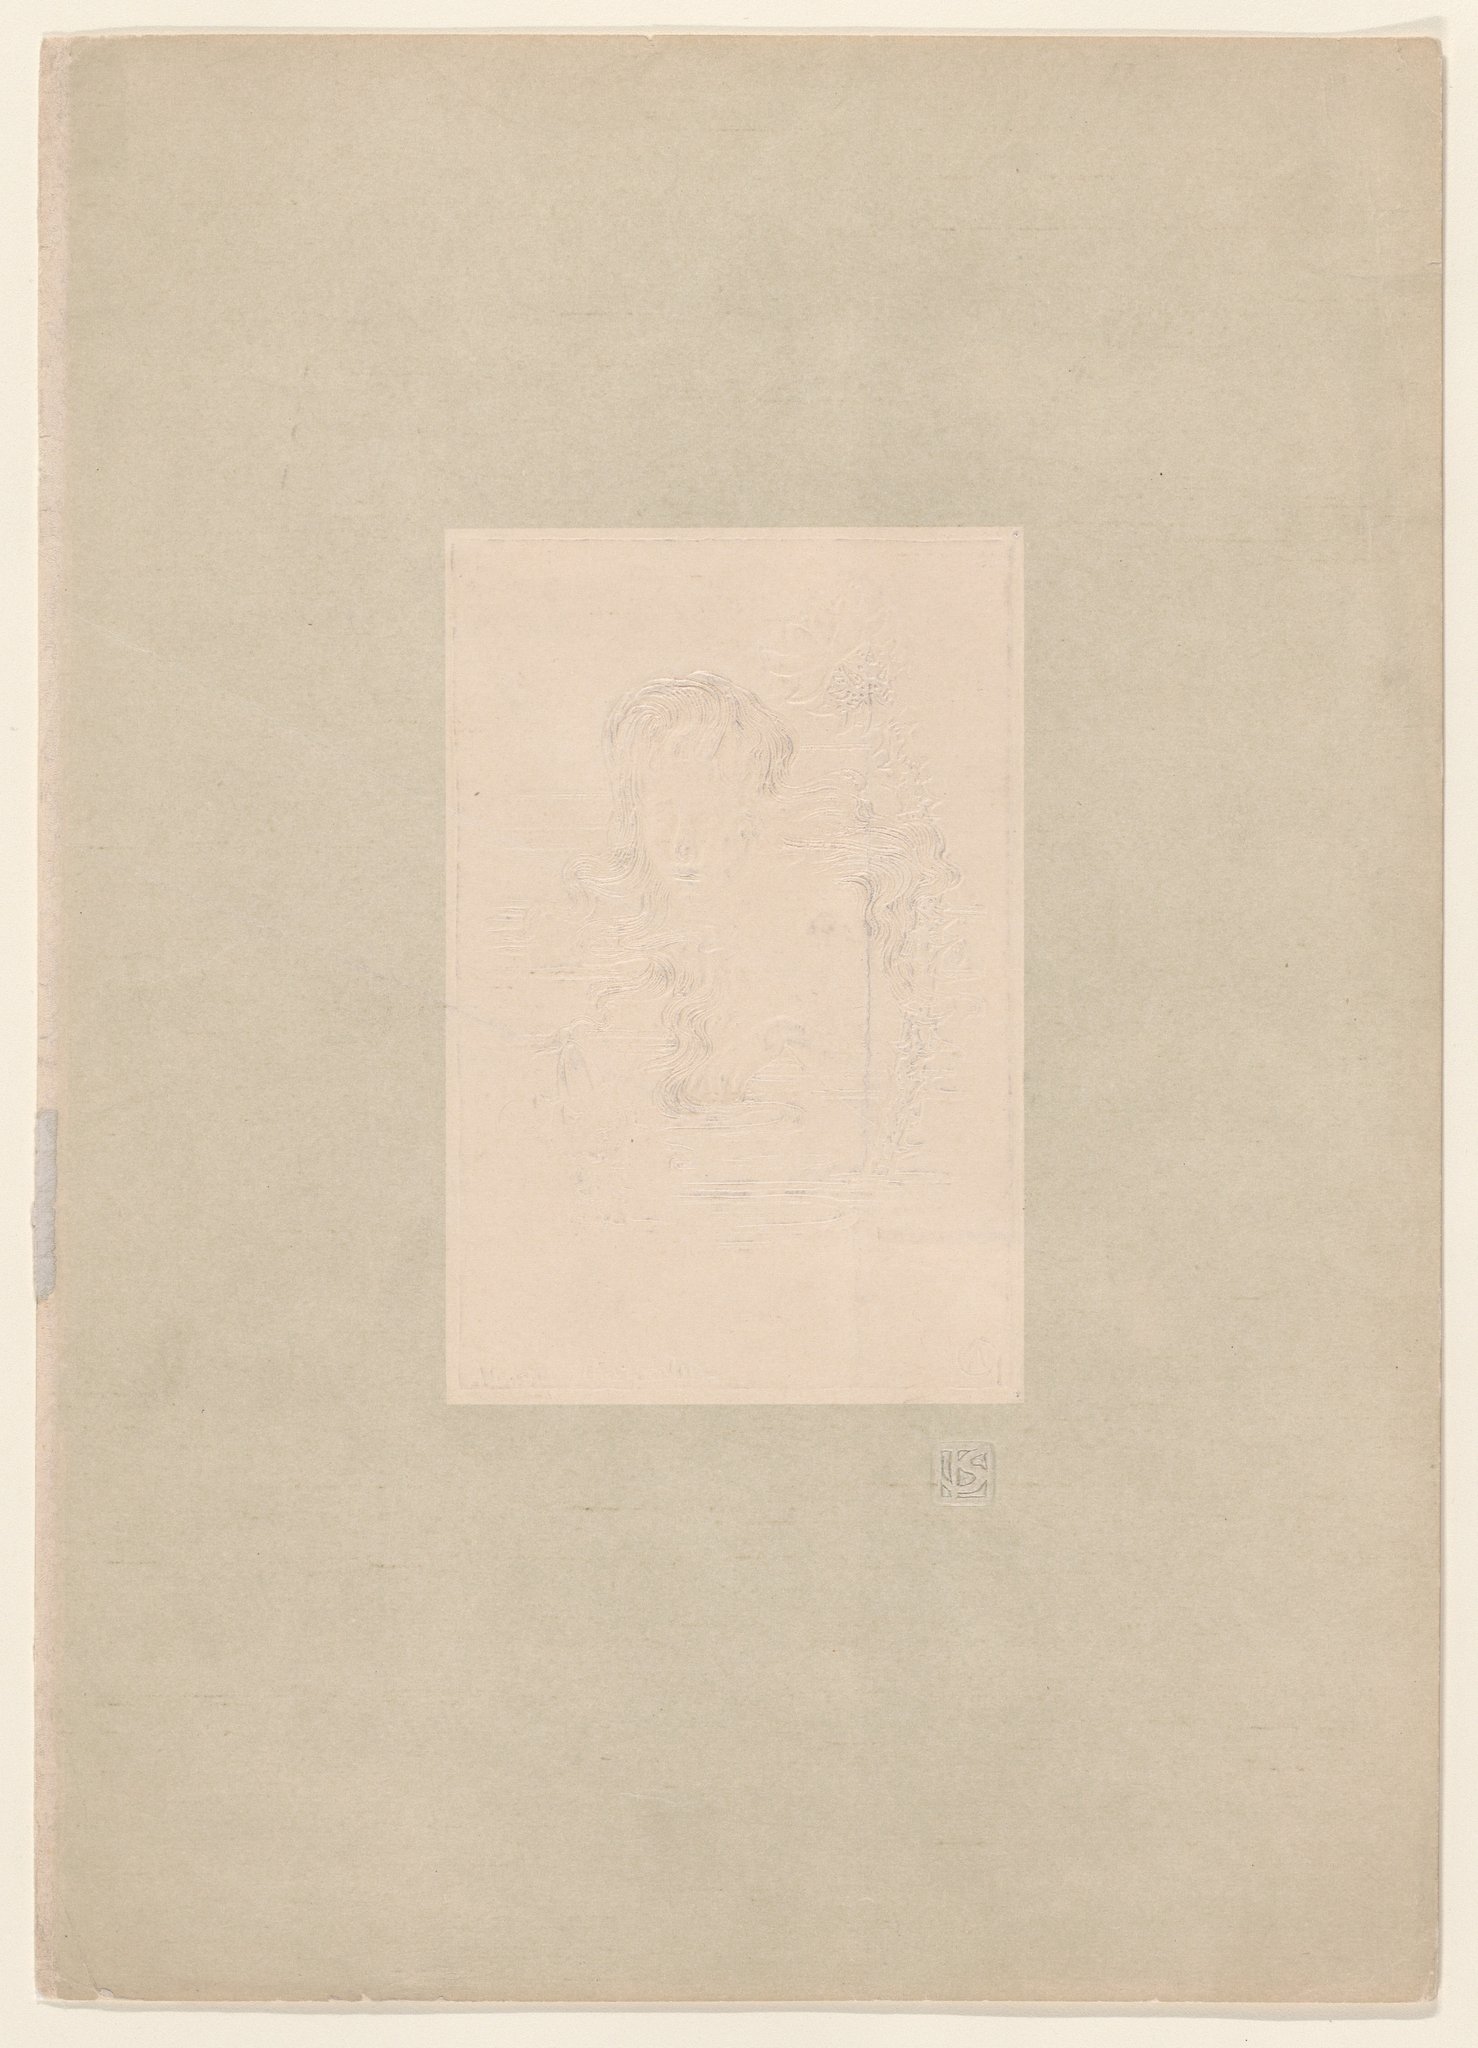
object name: print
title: Mermaid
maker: alexandre-louis-marie charpentier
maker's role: artist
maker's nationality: french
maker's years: 1856-1909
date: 1876-1909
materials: ink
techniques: repoussé